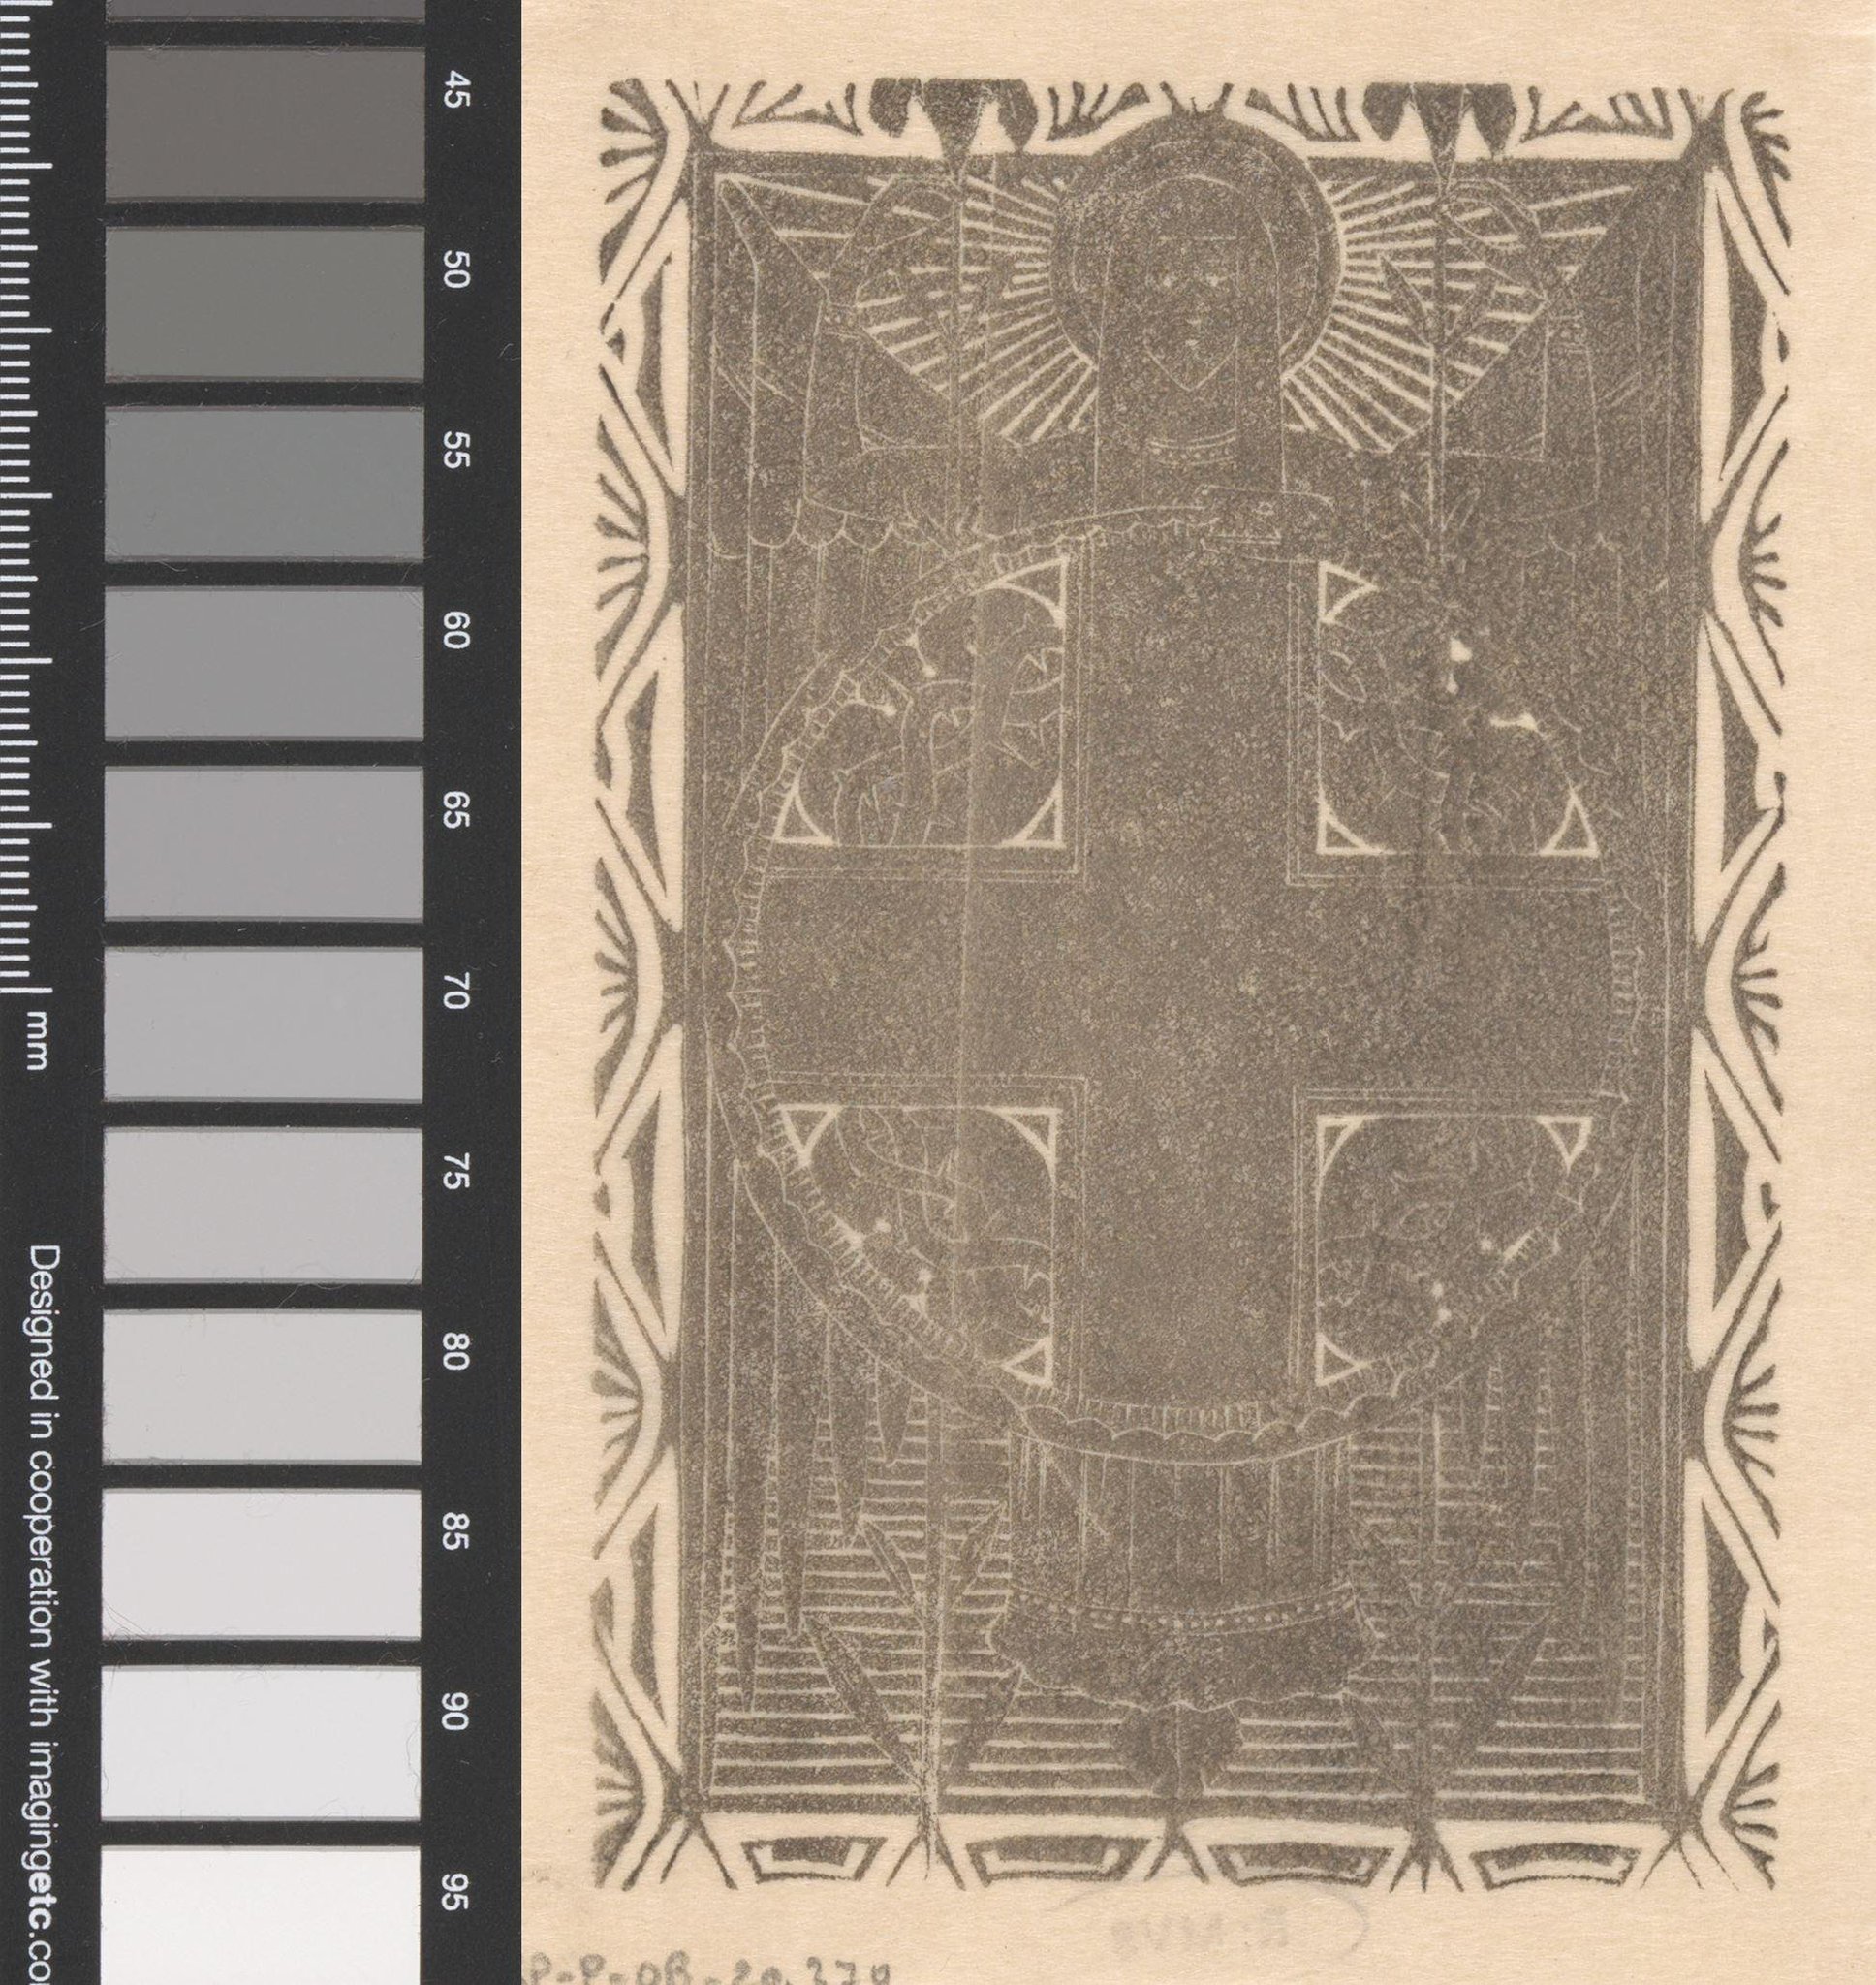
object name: prayer card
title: Kruis met ouroboros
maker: mathieu lauweriks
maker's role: designer, draughtsman, print maker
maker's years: 1864-1932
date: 1874-1932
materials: paper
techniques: woodcut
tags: nimbus, halo ~ radiance emanating from persons or things, the cross ~ symbols of christ, serpent ouroboros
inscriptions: collector's mark: Lugt 2228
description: Een kruis in een cirkel omgeven door een ouroboros, een slang die in zijn eigen staart bijt. Achter de cirkel een figuur met een nimbus die beide armen omhooghoudt.